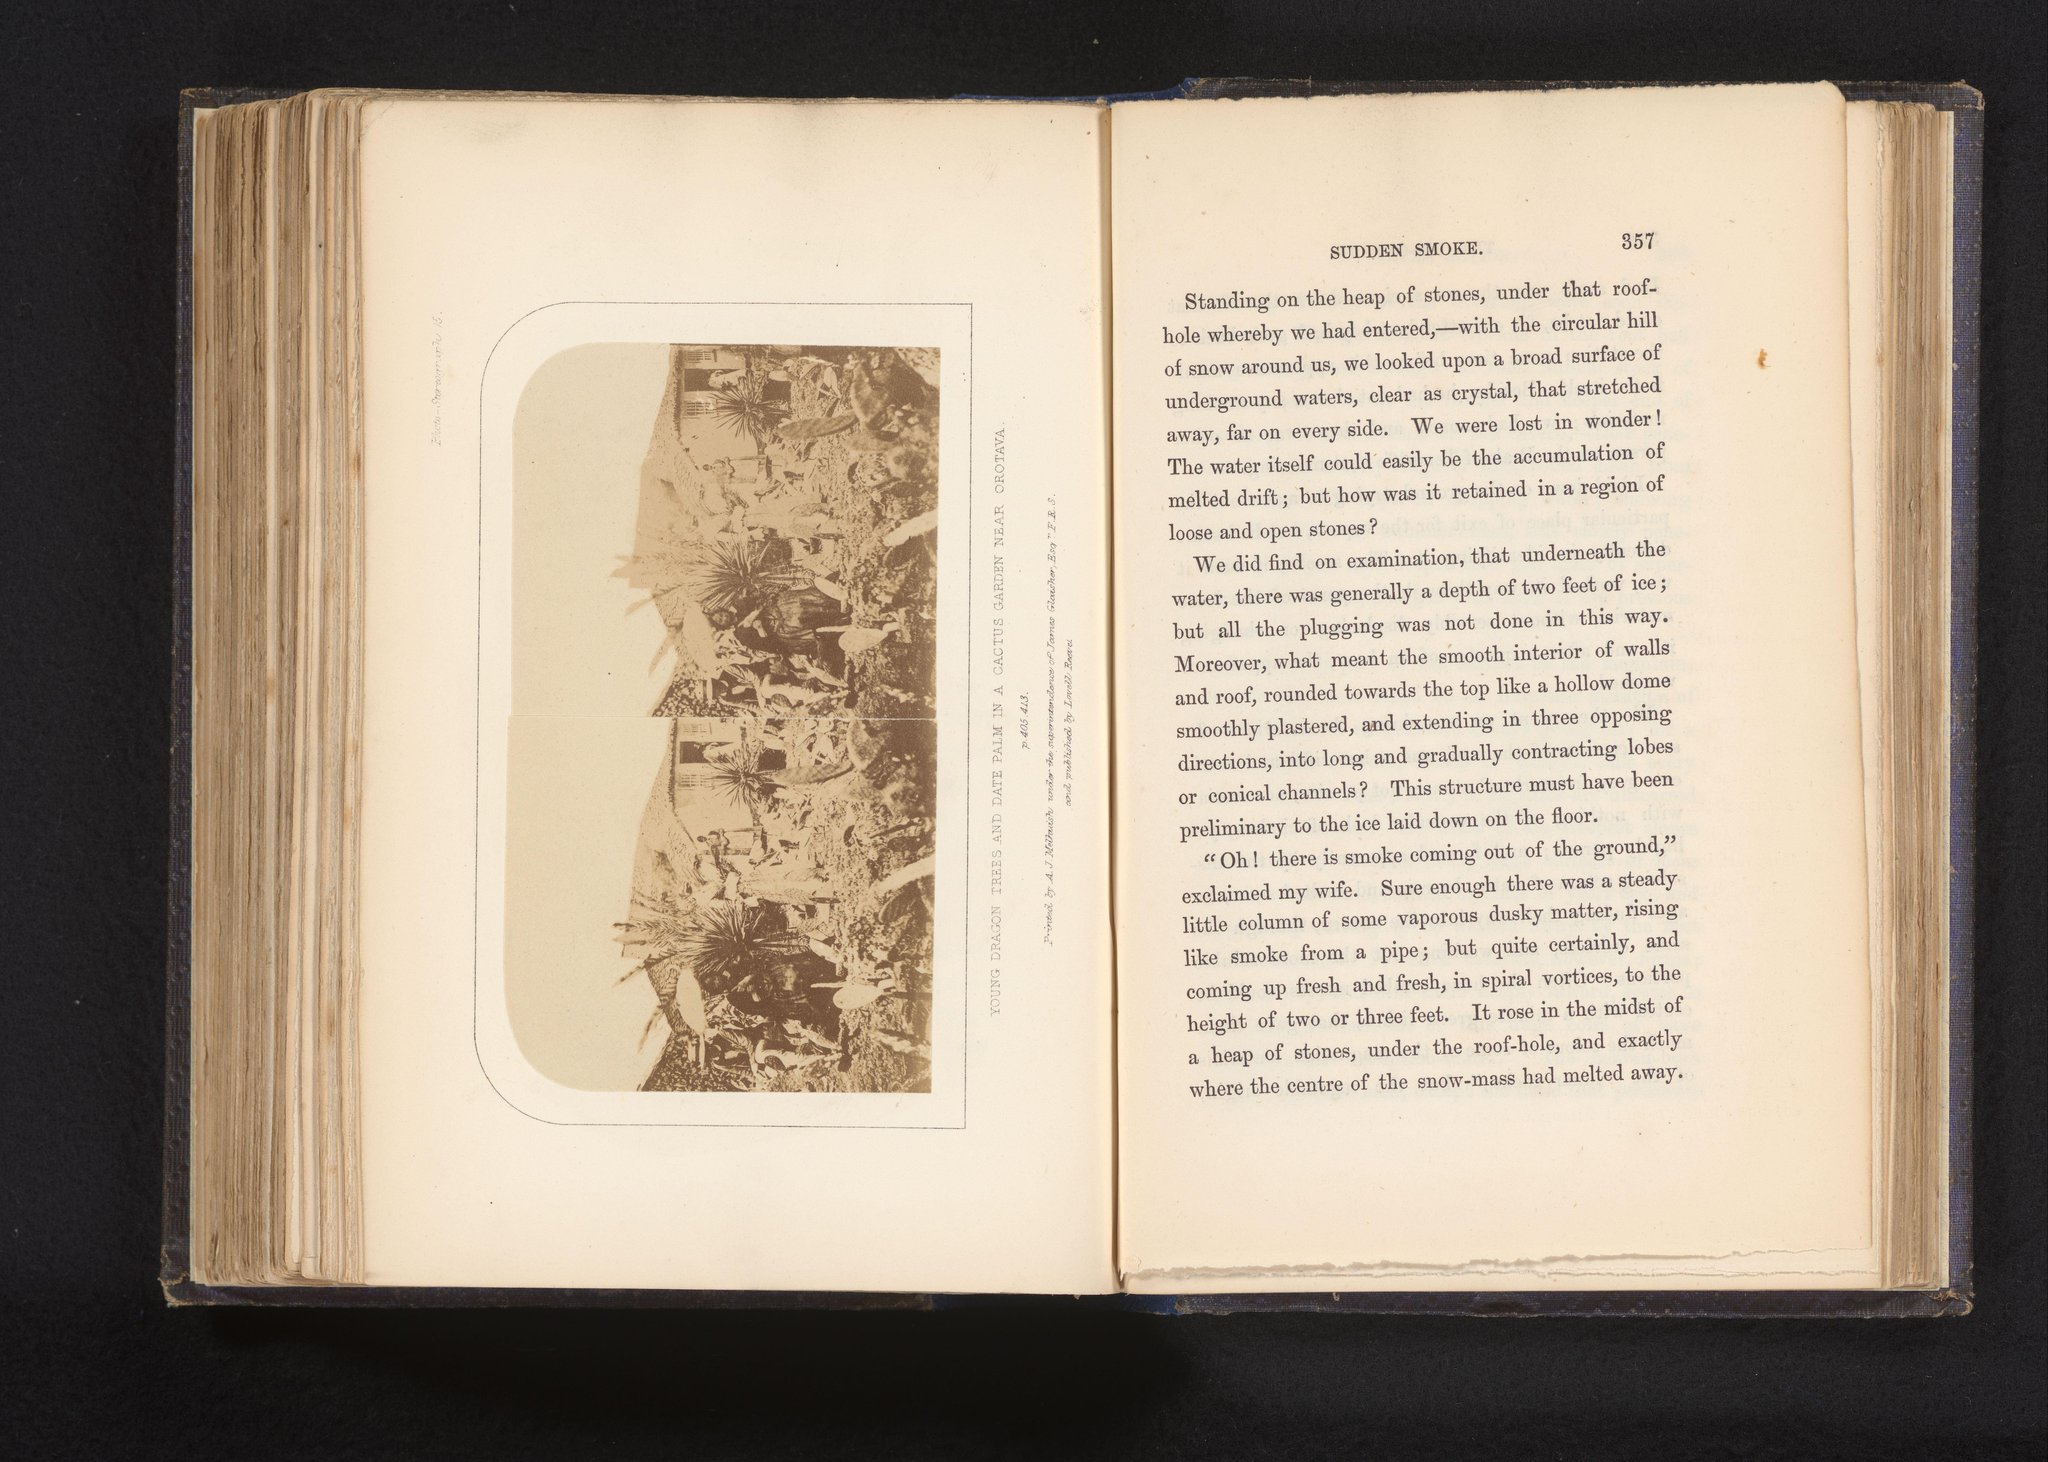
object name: page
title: Mensen bij drakenbloedbomen en dadelpalmen te La Orotava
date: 1856-1858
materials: paper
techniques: albumen print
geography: la orotava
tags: trees: date-palm, trees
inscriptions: inscription: ‘Photo-Stereograph 15.’